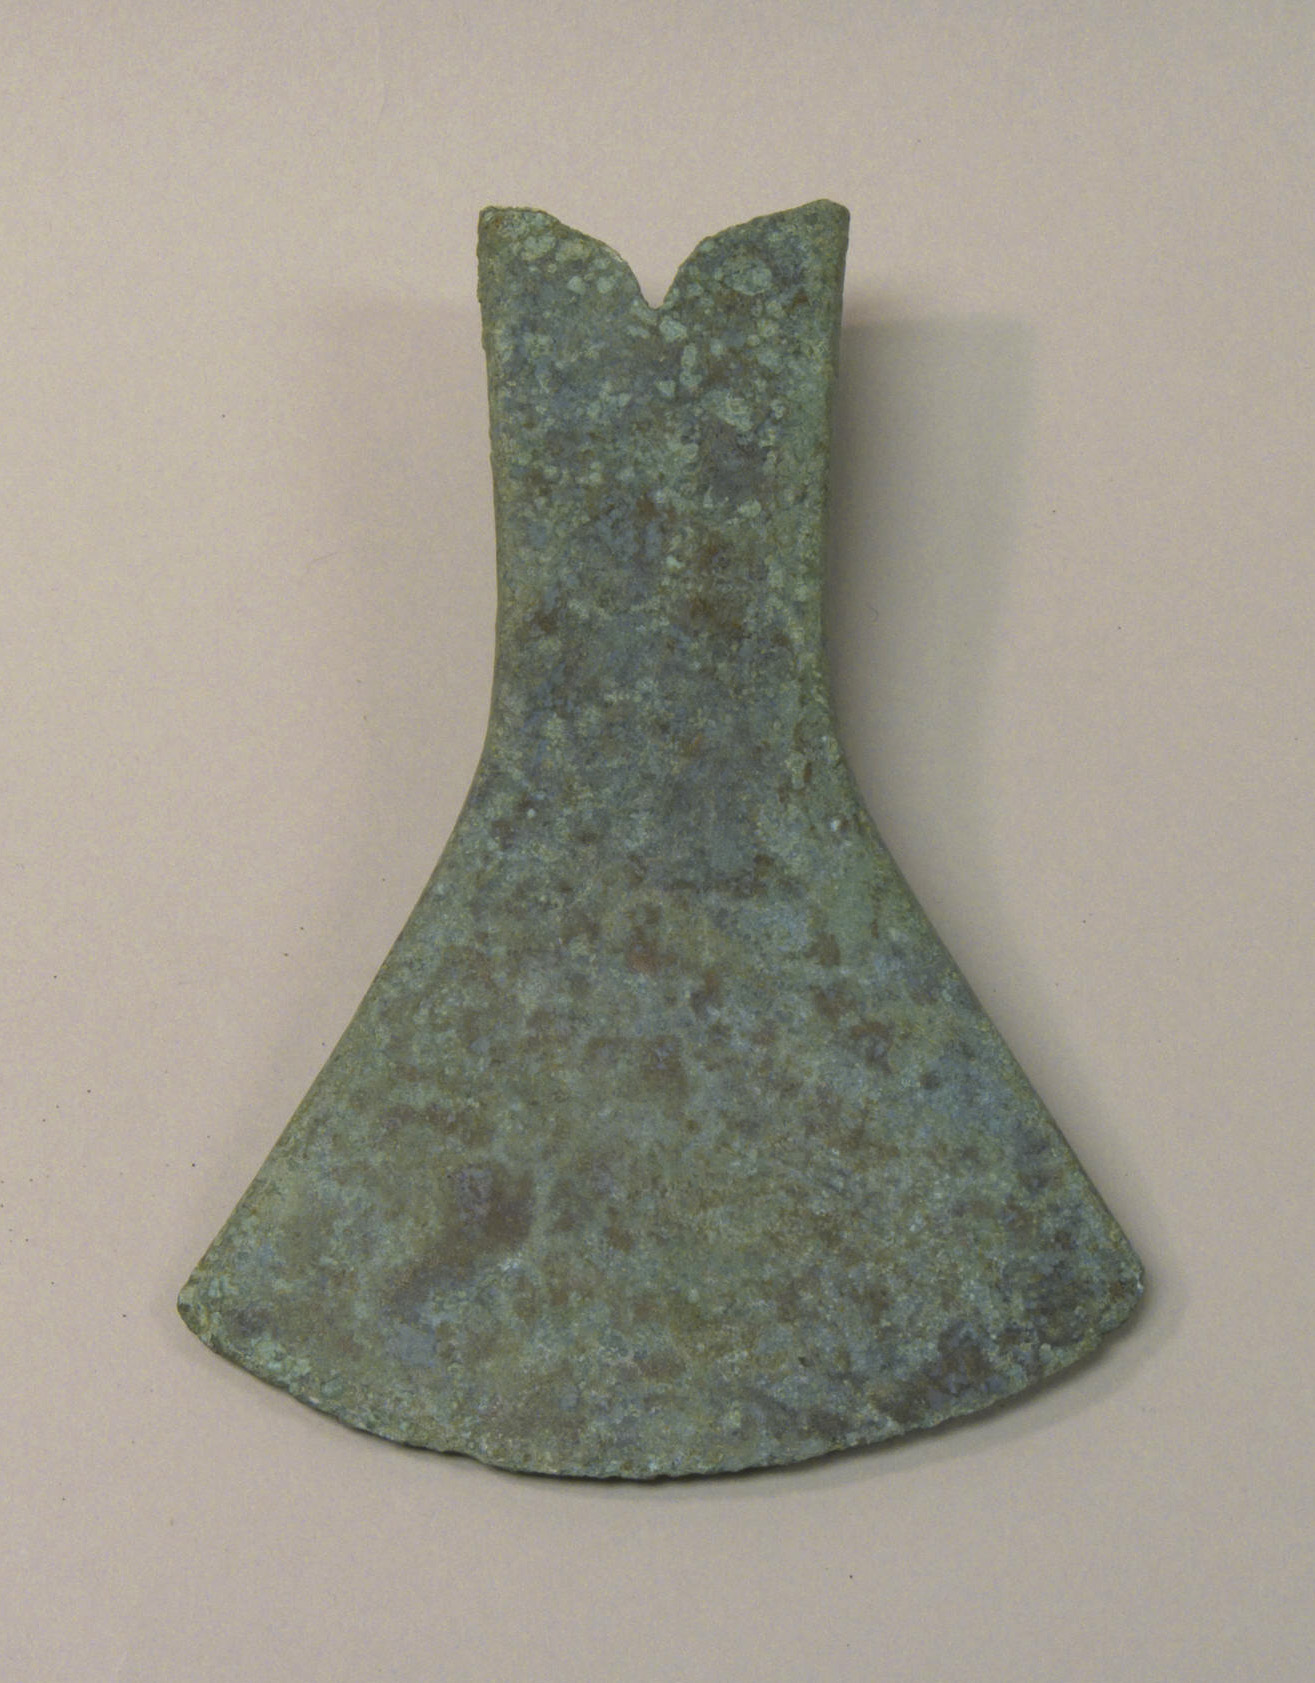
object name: hafted ax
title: Swallowtail Hafted Ax with Chevron Design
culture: indonesian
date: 500 BCE-300 CE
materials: bronze